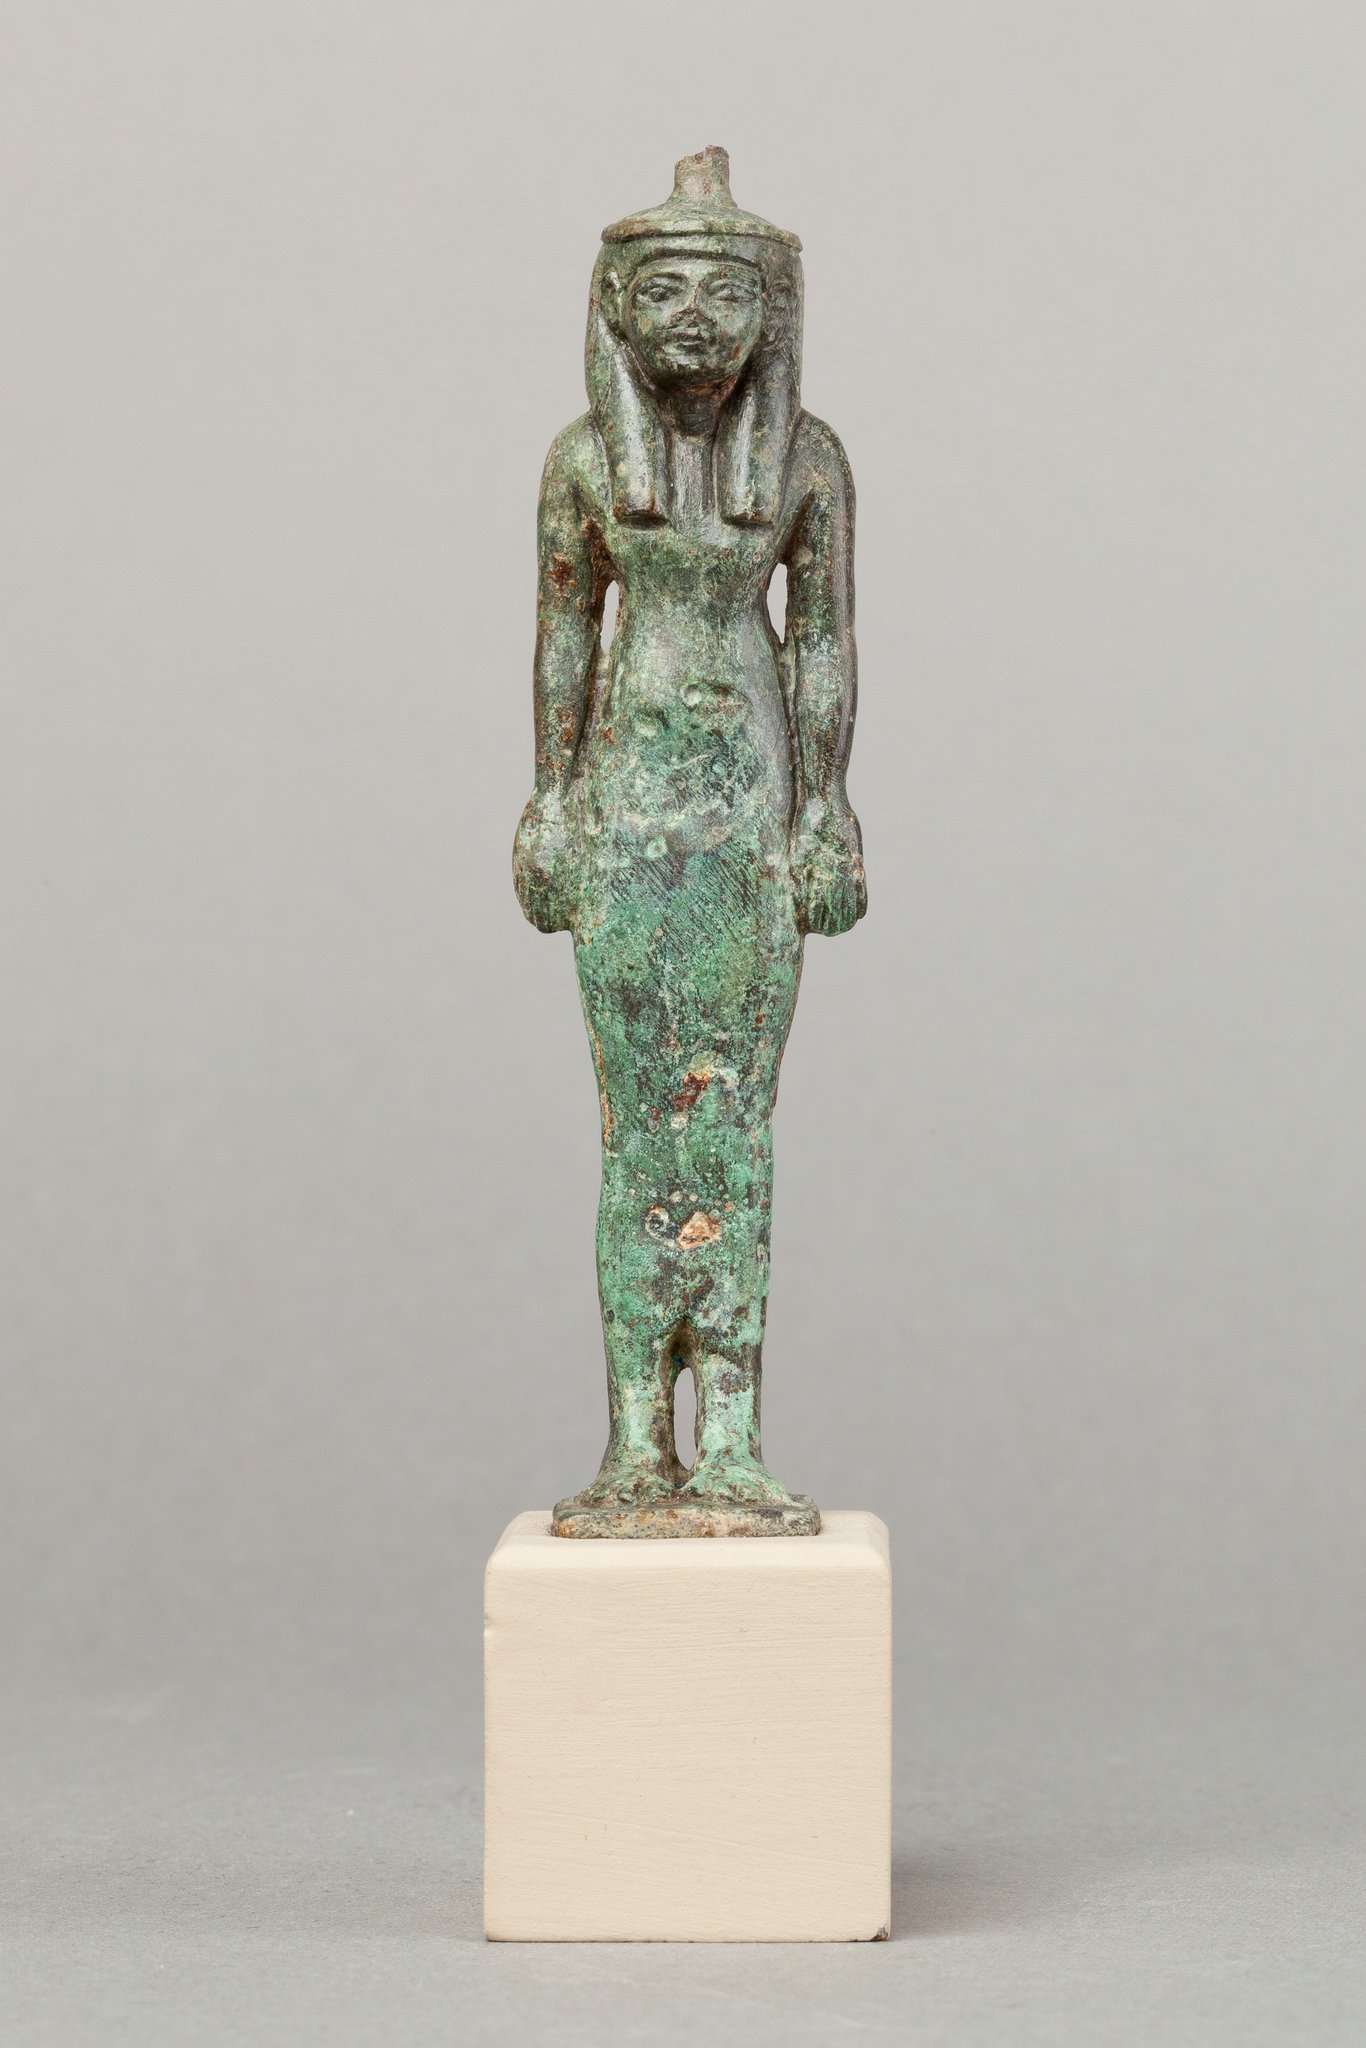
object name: statuette, maat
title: Maat?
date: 664-630 BCE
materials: metal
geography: egypt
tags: goddess